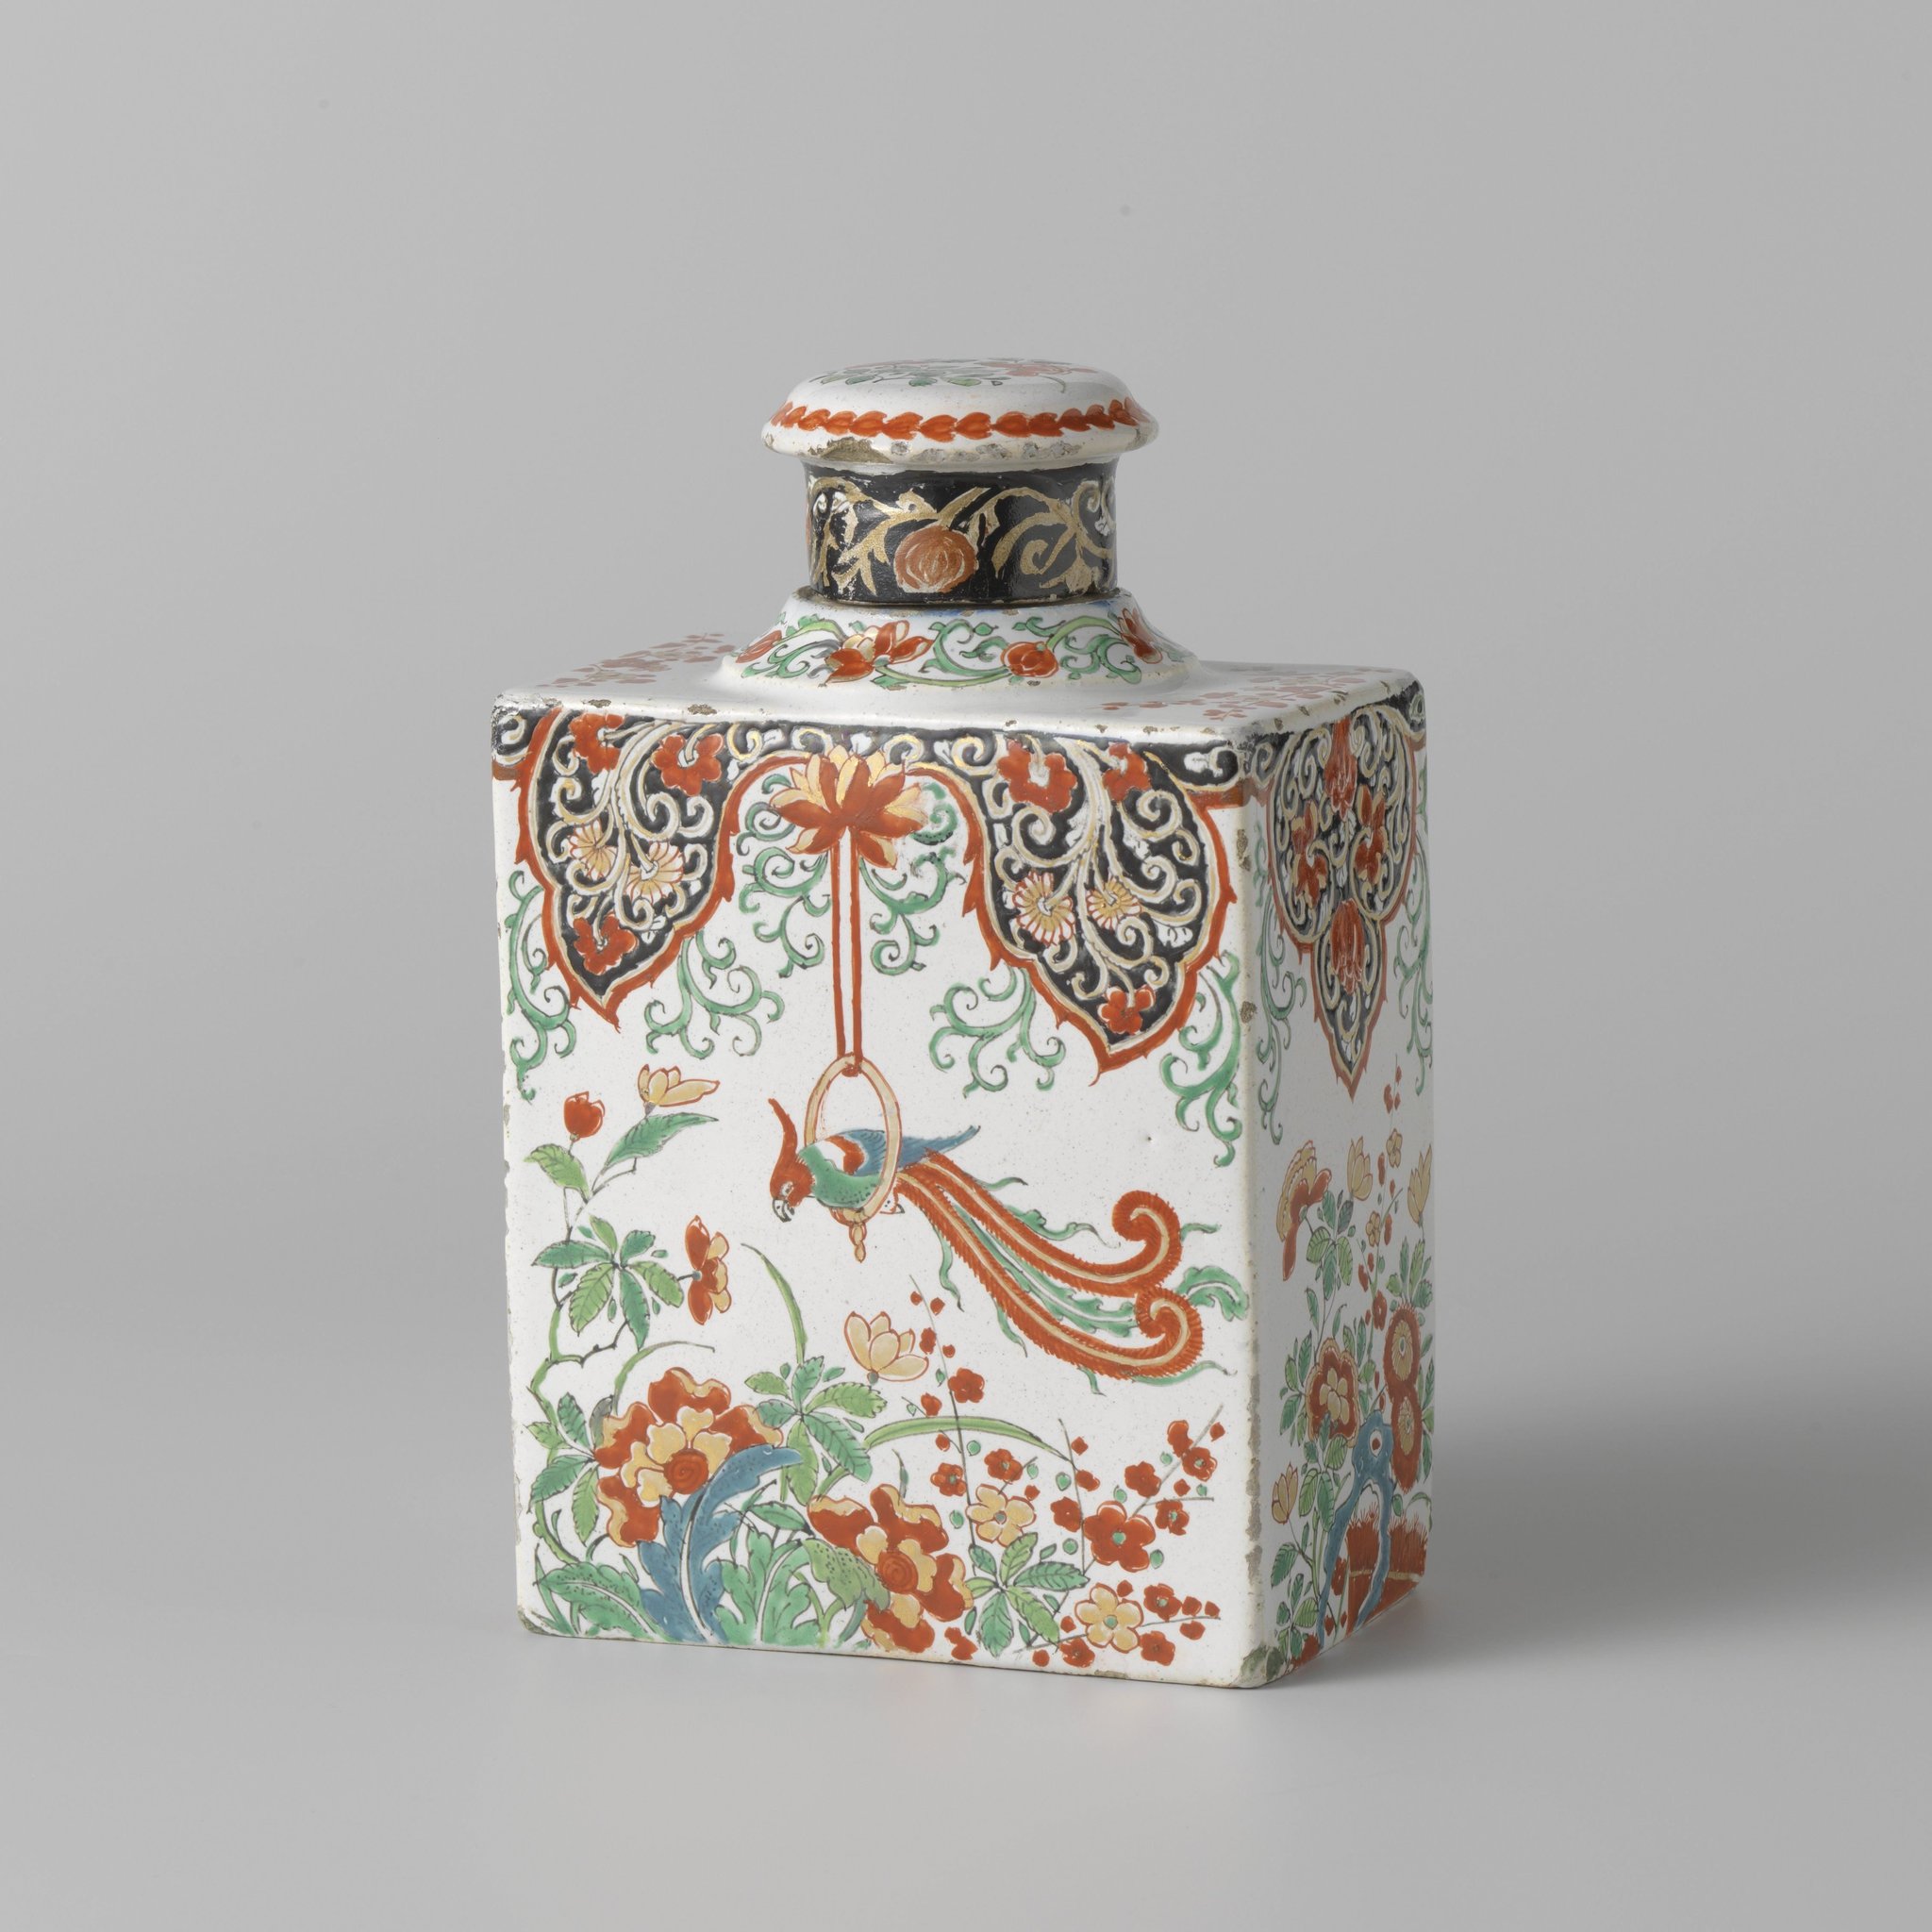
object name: tea caddy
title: Tea canister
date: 1715-1725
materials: earthenware, glaze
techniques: kiln, painted, polychromy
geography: delft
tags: ornaments ~ art, ornamental birds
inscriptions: mark: ‘PAK(ineen)’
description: Rechthoekige theebus met deksel veelkleurig (blauw, rood, goud en zwart) beschilderd met een vogel in een ring, lambrequins en bloemtakken. Gemerkt in rood.